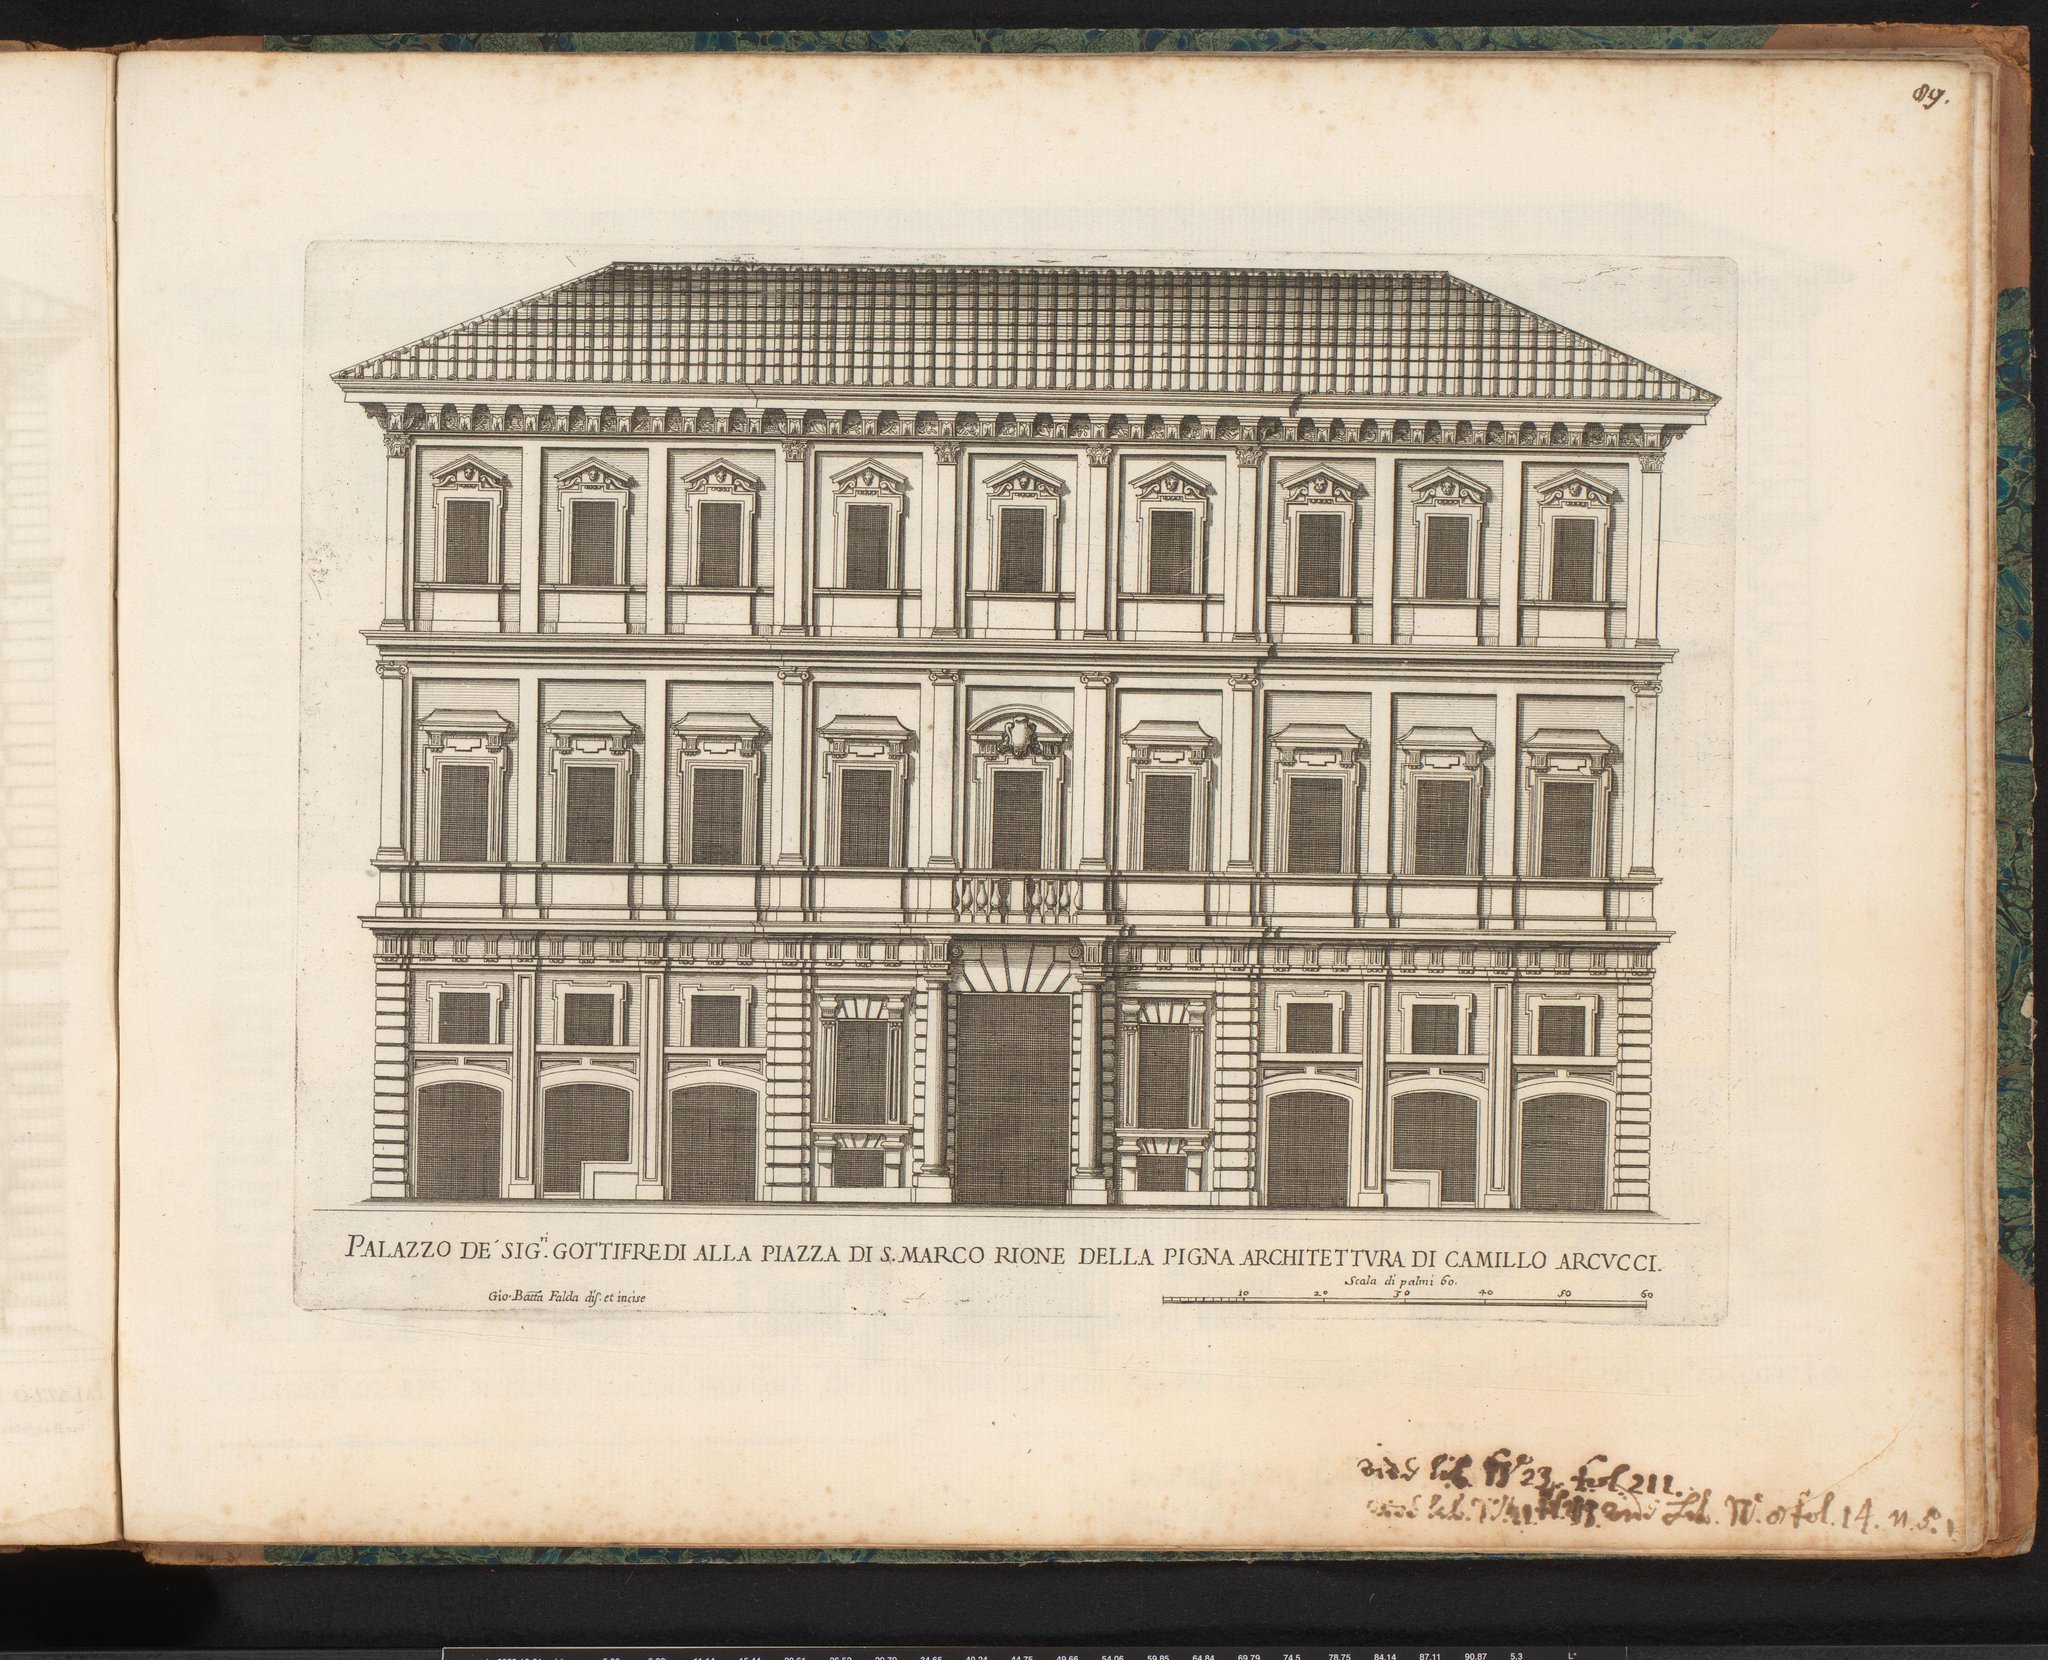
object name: album leaf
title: Romeinse paleizen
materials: paper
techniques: etching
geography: rome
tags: palace, façade (of house or building)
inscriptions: inscription: ‘Ende lib. No. 23. fol. 211./ Ende lib. No. 21 [...] Ende lib. No. 8 fol. 14. n. 5. 1.’, number: ‘89’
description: Deze prent maakt deel uit van de reeks getiteld: Palazzi di Roma. Deze reeks bestaat uit twee boeken. Boek één getiteld: Palazzi di Roma dei più celebri architetti..., bestaat uit 44 prenten die worden toegeschreven aan Giovanni Battista Falda (naam staat enkel op prent 27) en uitgegeven door Giovanni Giacomo de'Rossi. Deze 44 prenten zijn bekend in twee staten (met en zonder nummer). Boek twee getiteld: Nuovi disegni dell'architetture... libro secondo, bevat 66 prenten door Giovanni Battista Falda en Simone Felice. Deze 66 prenten zijn bekend in twee staten (met en zonder nummer).